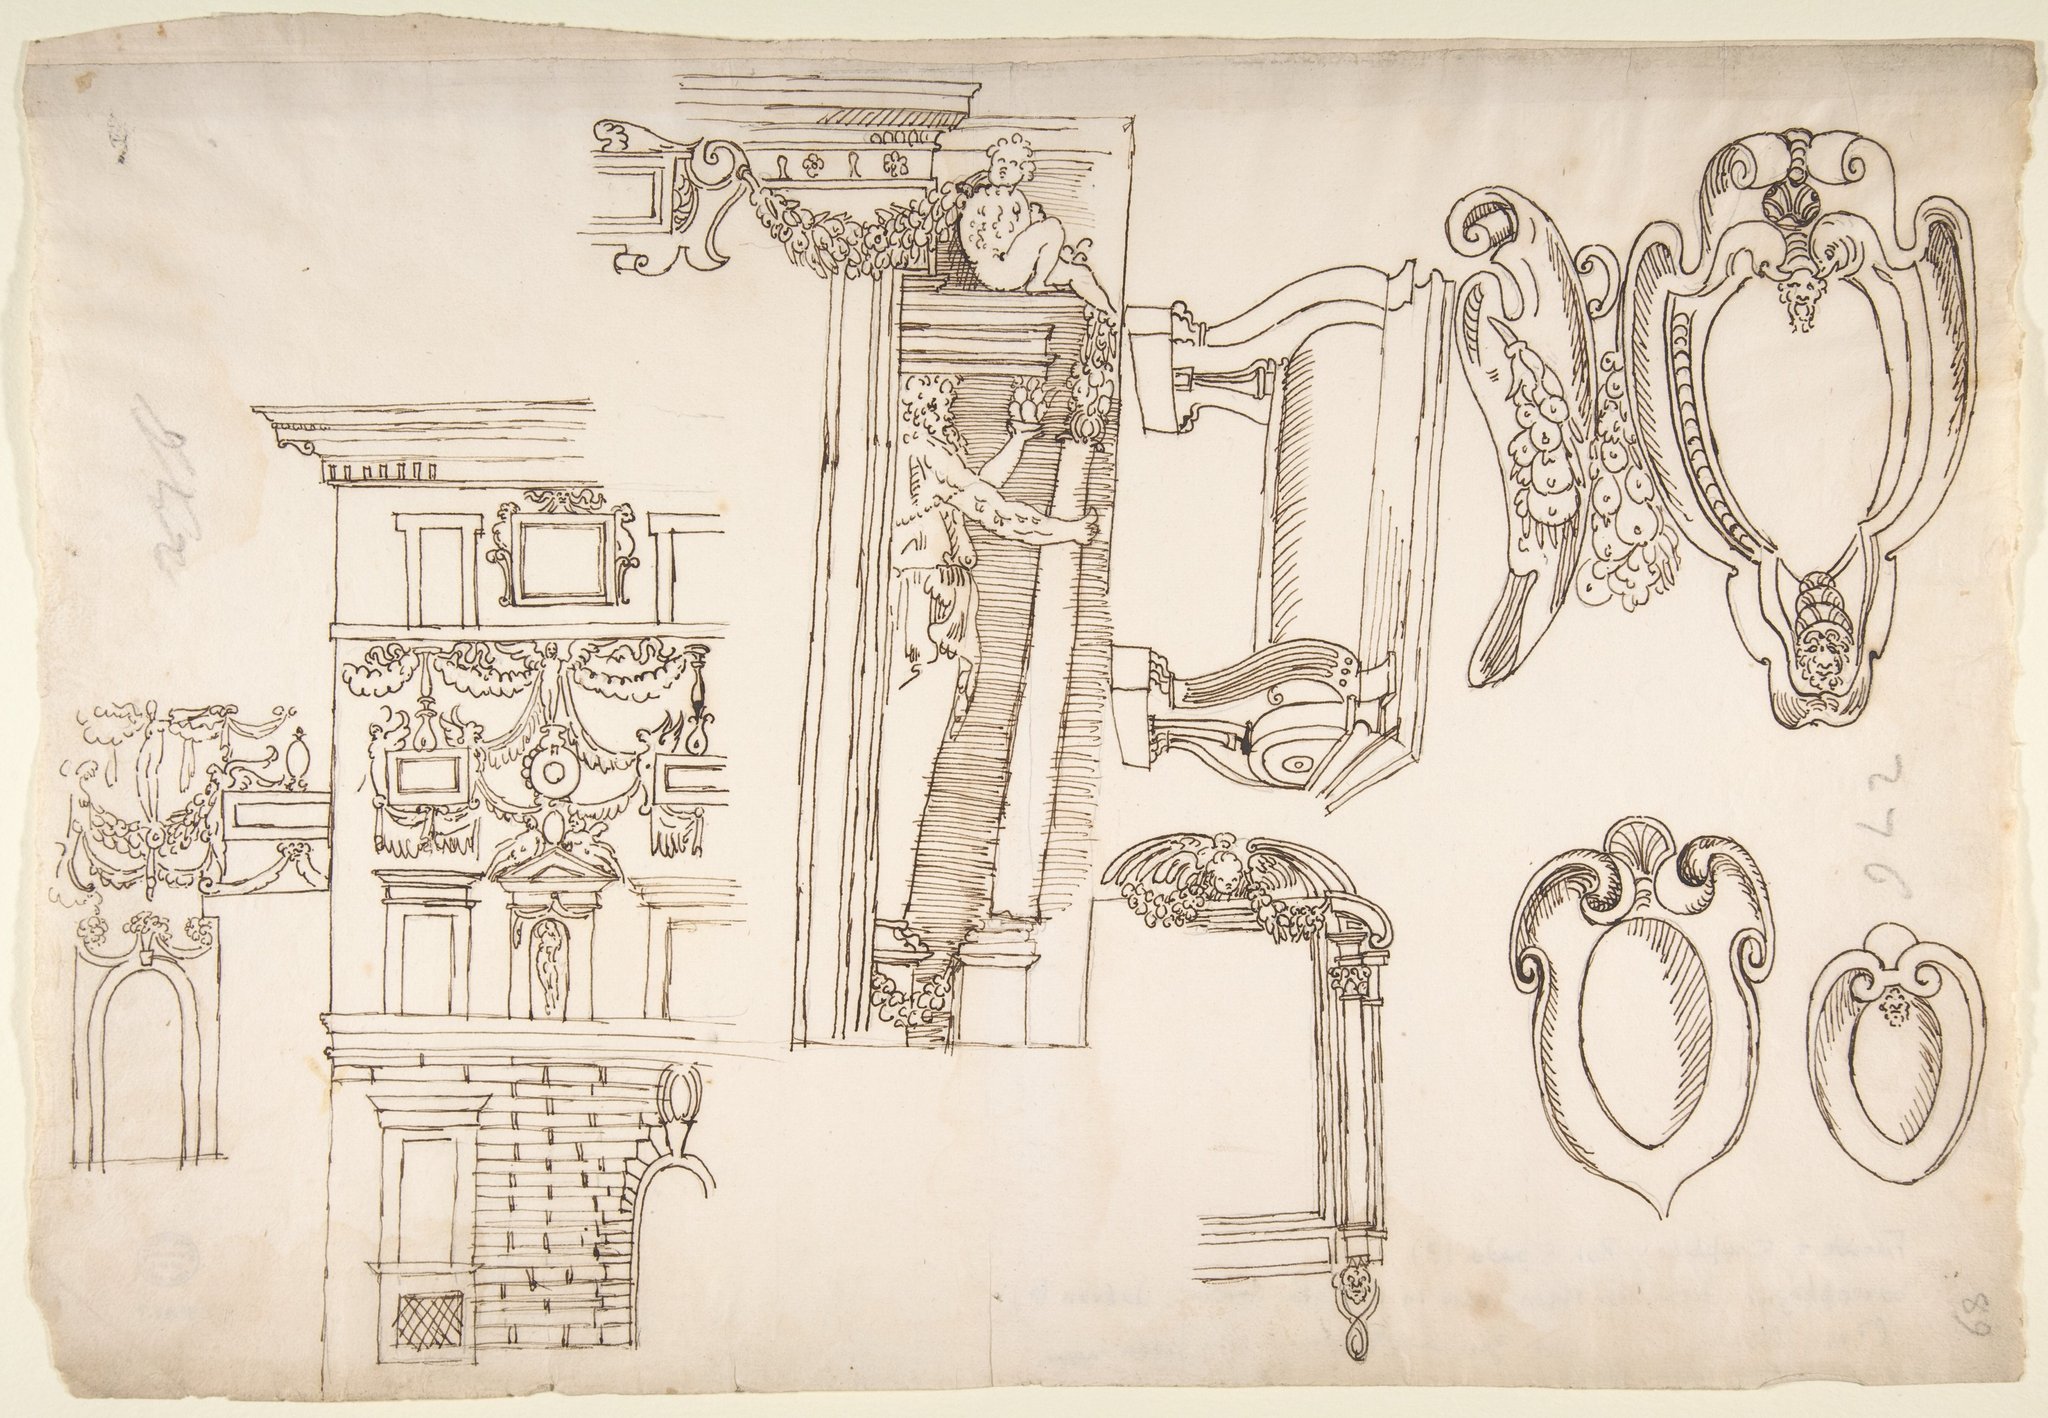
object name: drawing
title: Palazzo Capodiferro (Spada), partial elevation, details; Santa Trinità dei Monti, Orsini Chapel, frame, elevation; various details, perspective (recto) blank (verso)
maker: anonymous, french, 16th century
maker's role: draftsman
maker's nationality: french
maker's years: 1500-1600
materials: chalk, ink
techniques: incising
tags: ornament